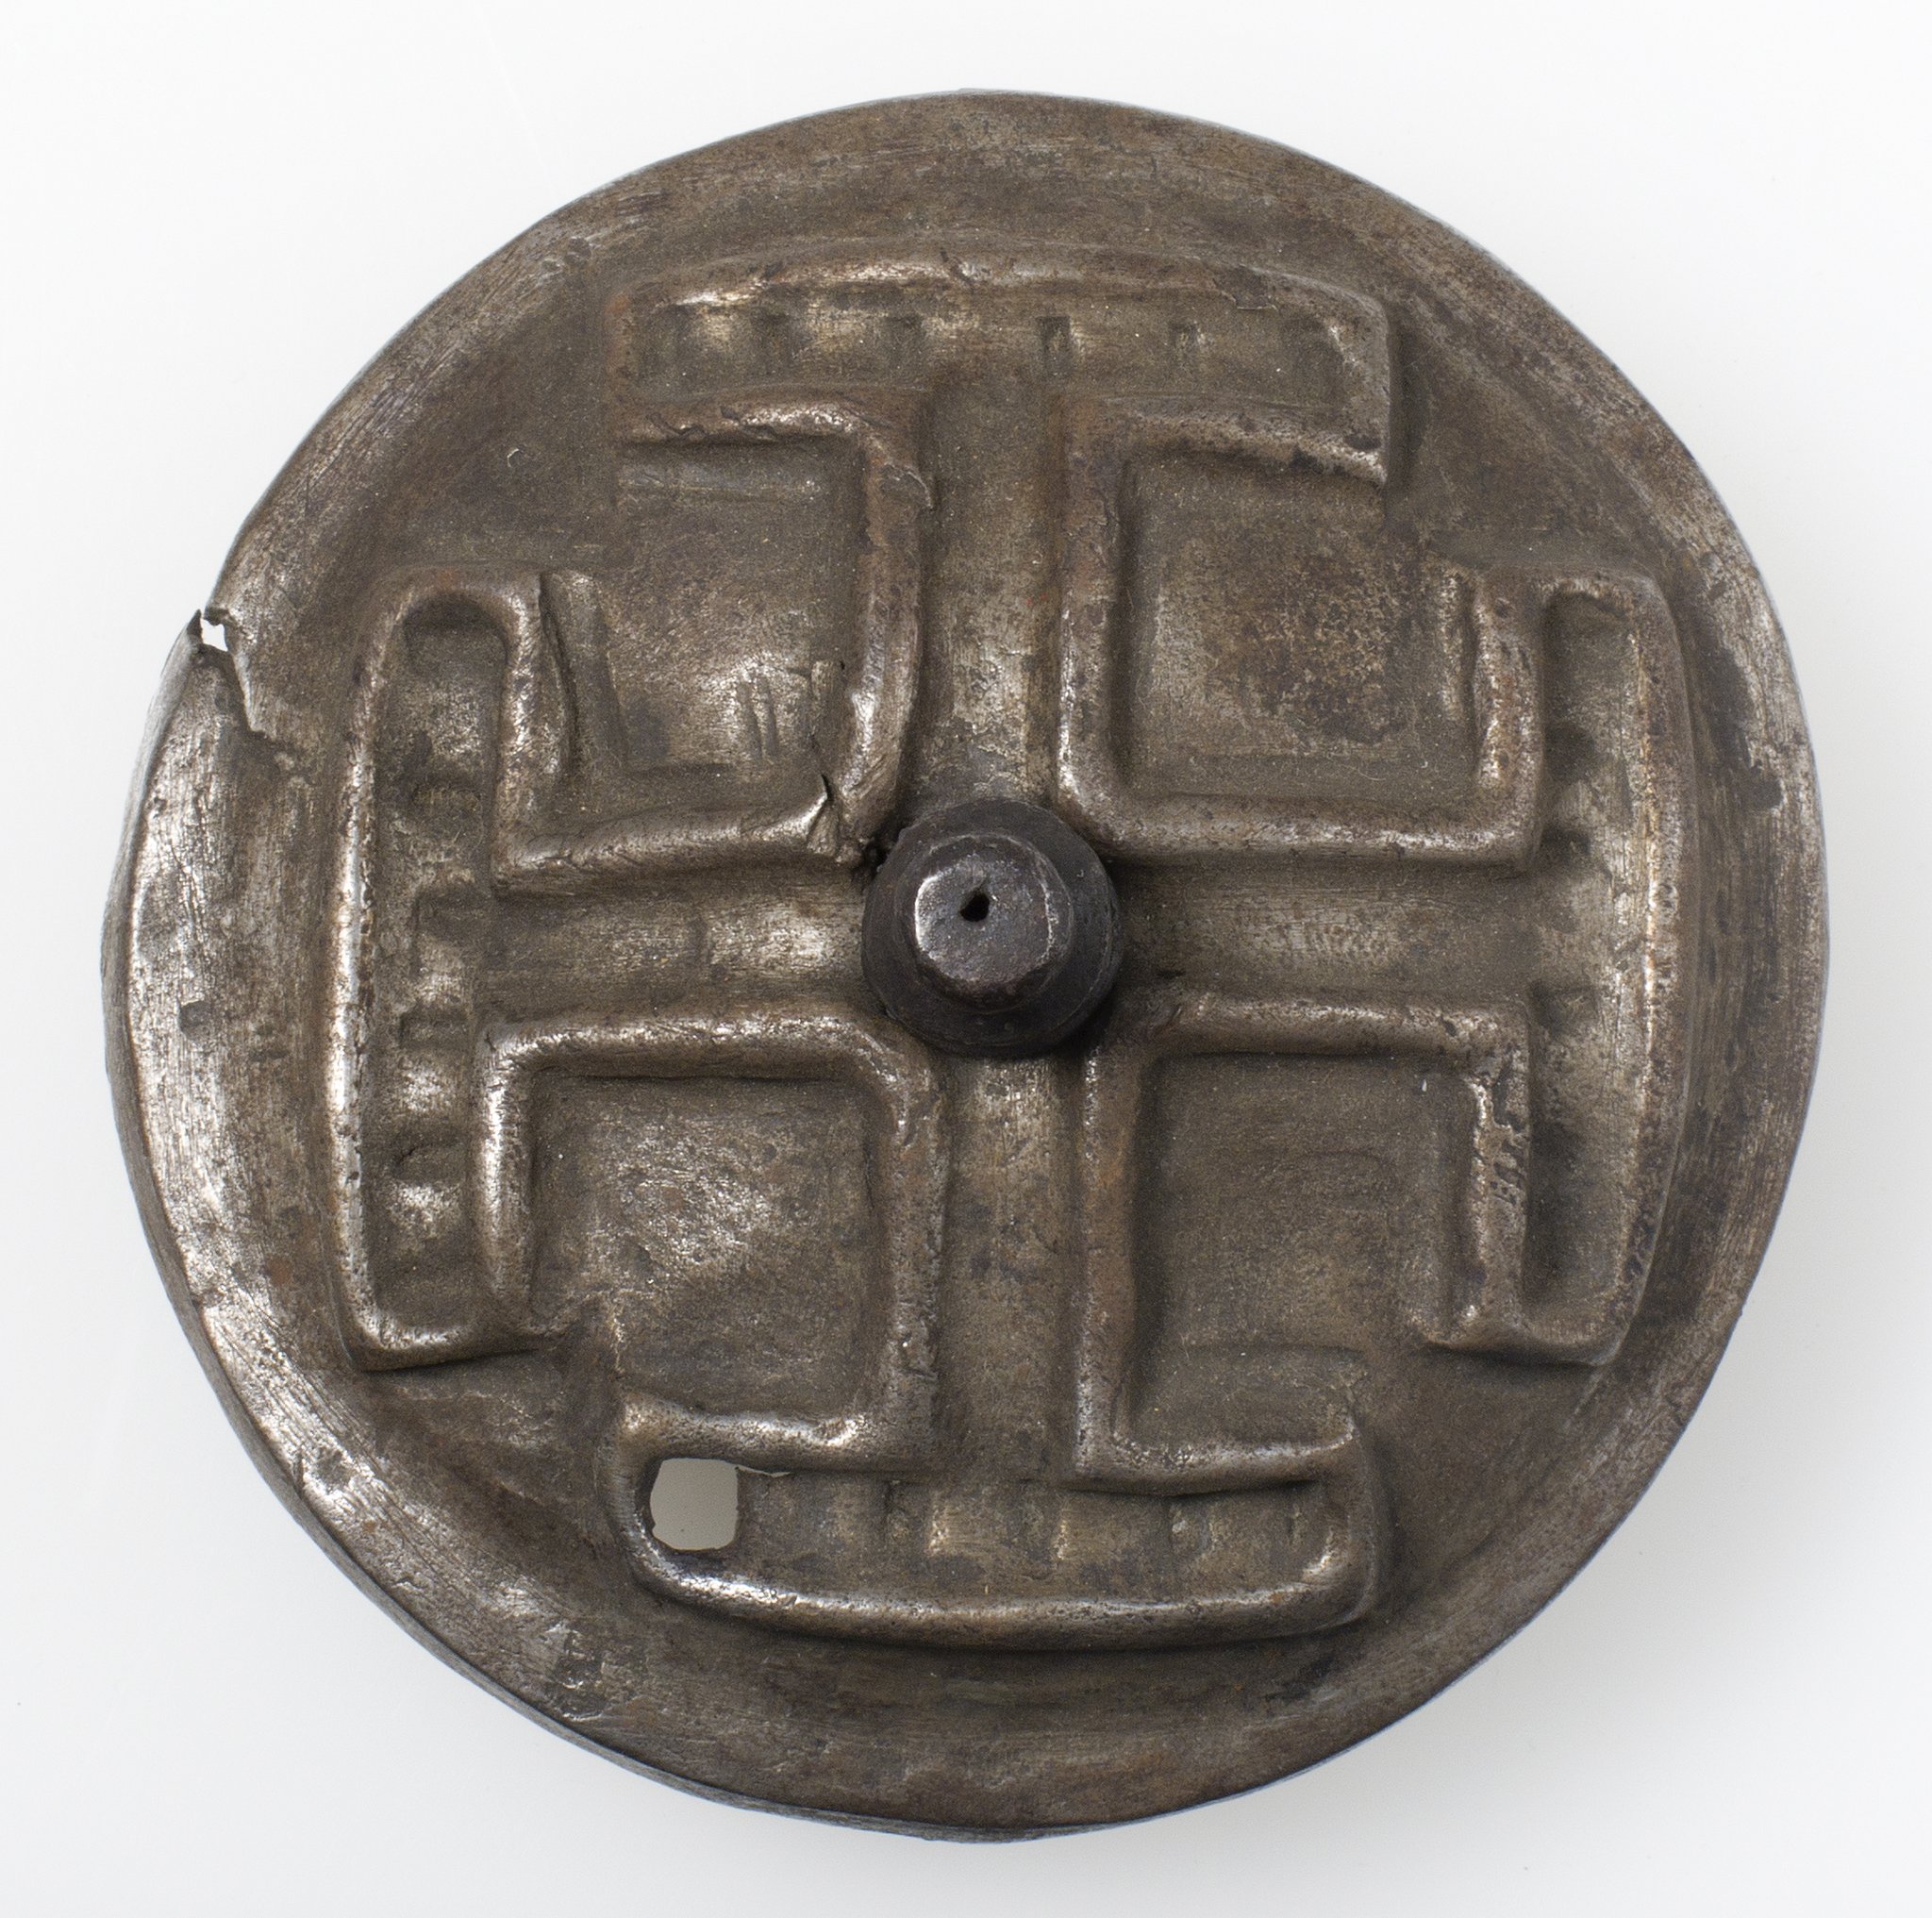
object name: plate and nail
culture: european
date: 1401-1600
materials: iron